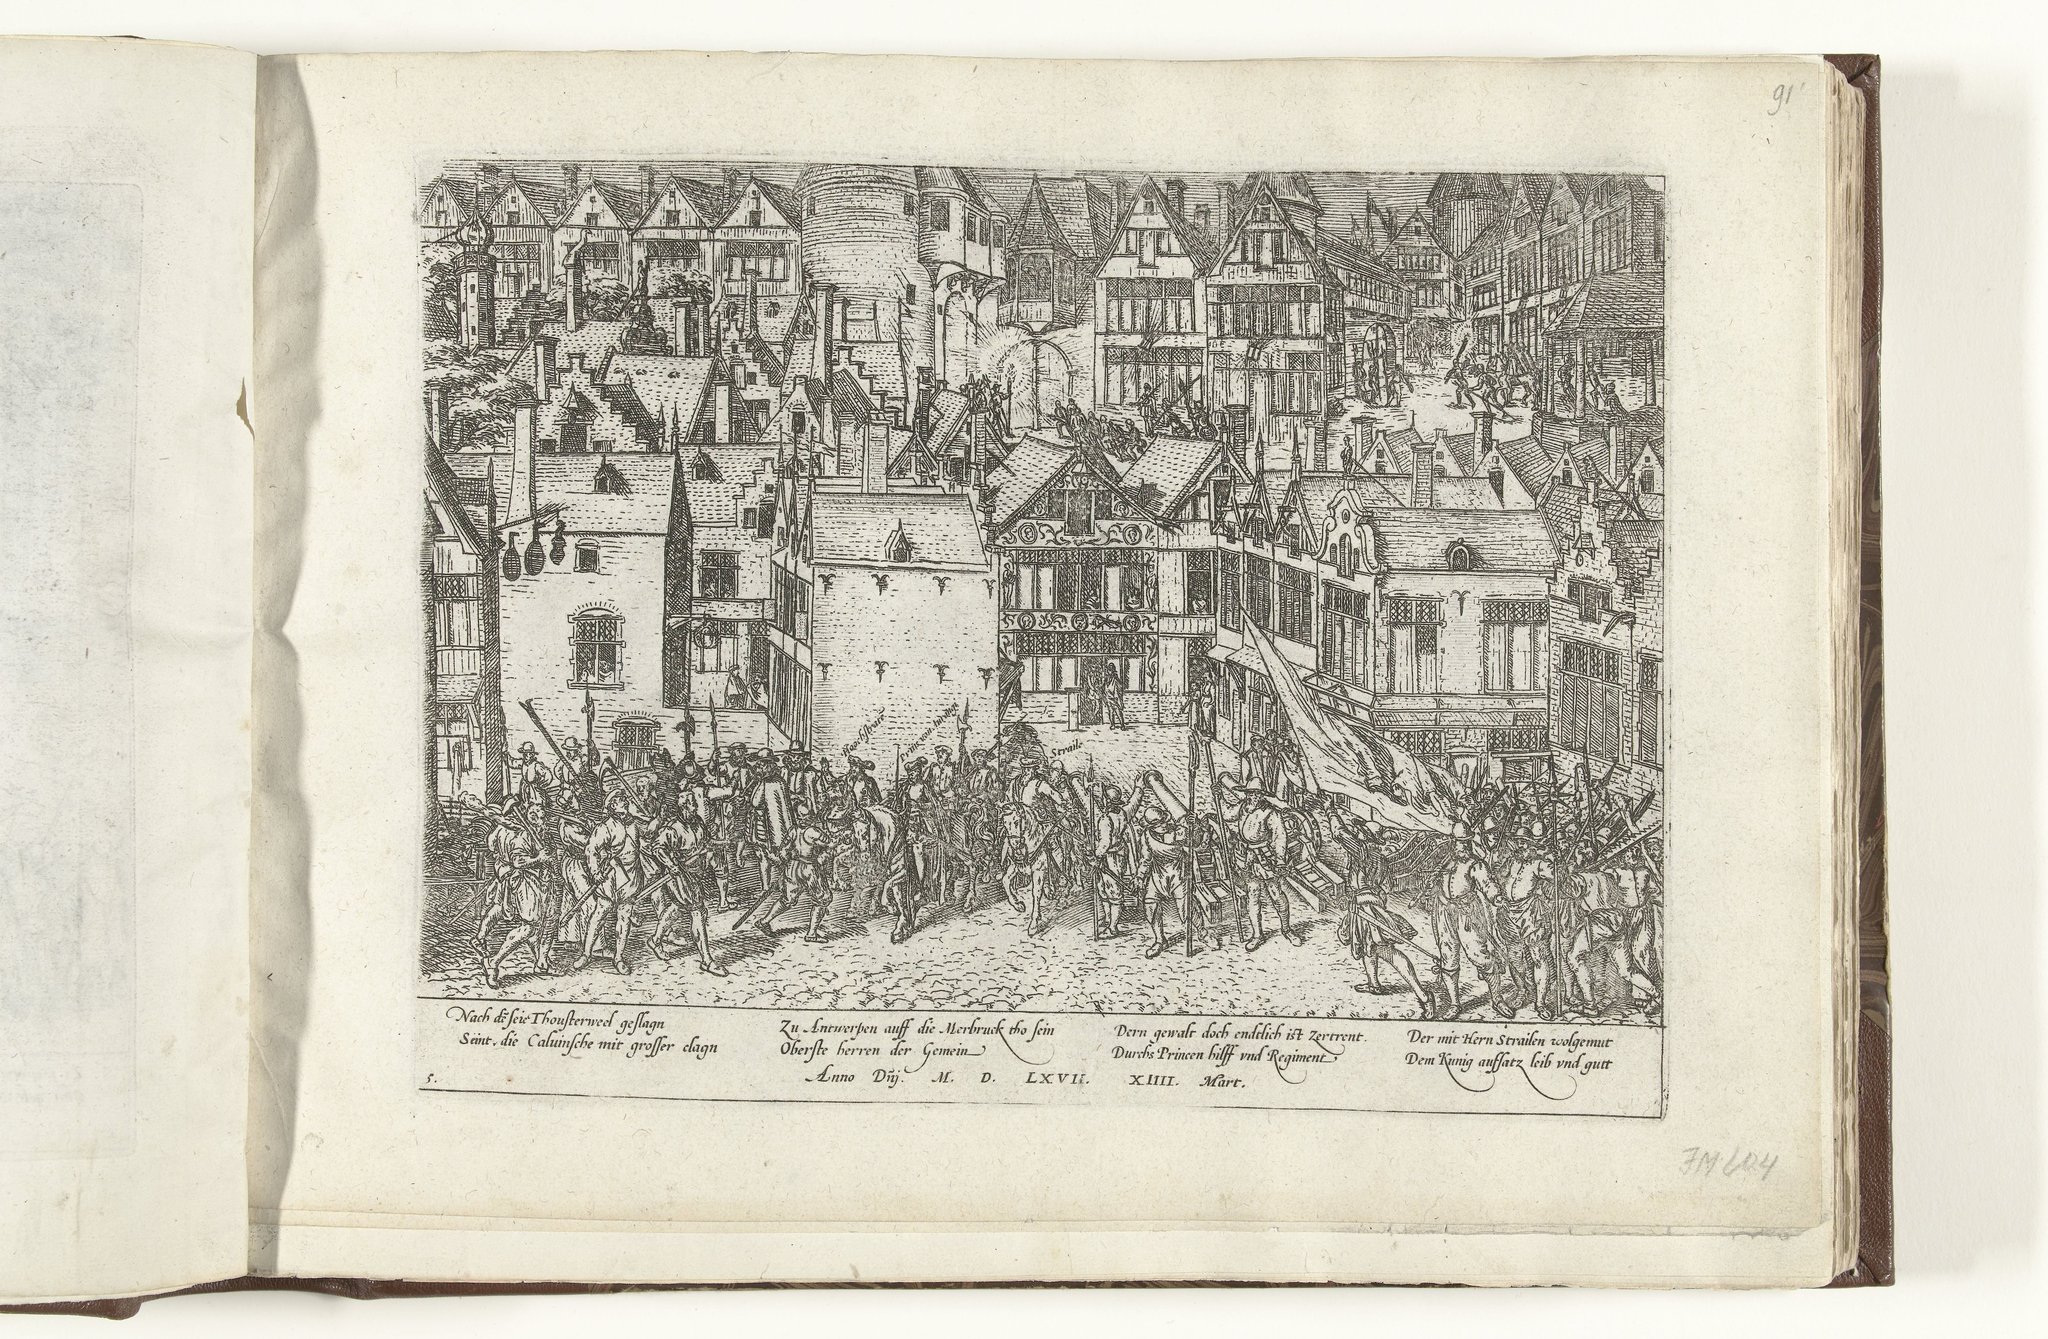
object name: print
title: Calvinistisch oproer in Antwerpen bedwongen, 1567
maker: frans hogenberg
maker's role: print maker, publisher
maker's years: 1538-1590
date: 1567-1570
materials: paper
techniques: etching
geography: cologne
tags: delft, william i (prince of orange), antwerp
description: Burgemeester Anton van Straelen, Hoogstraten en Willem van Oranje stillen calvinistisch oproer op de Meir in Antwerpen, 14 maart 1567. Met onderschrift van 8 regels in het Duits. Genummerd: 5.